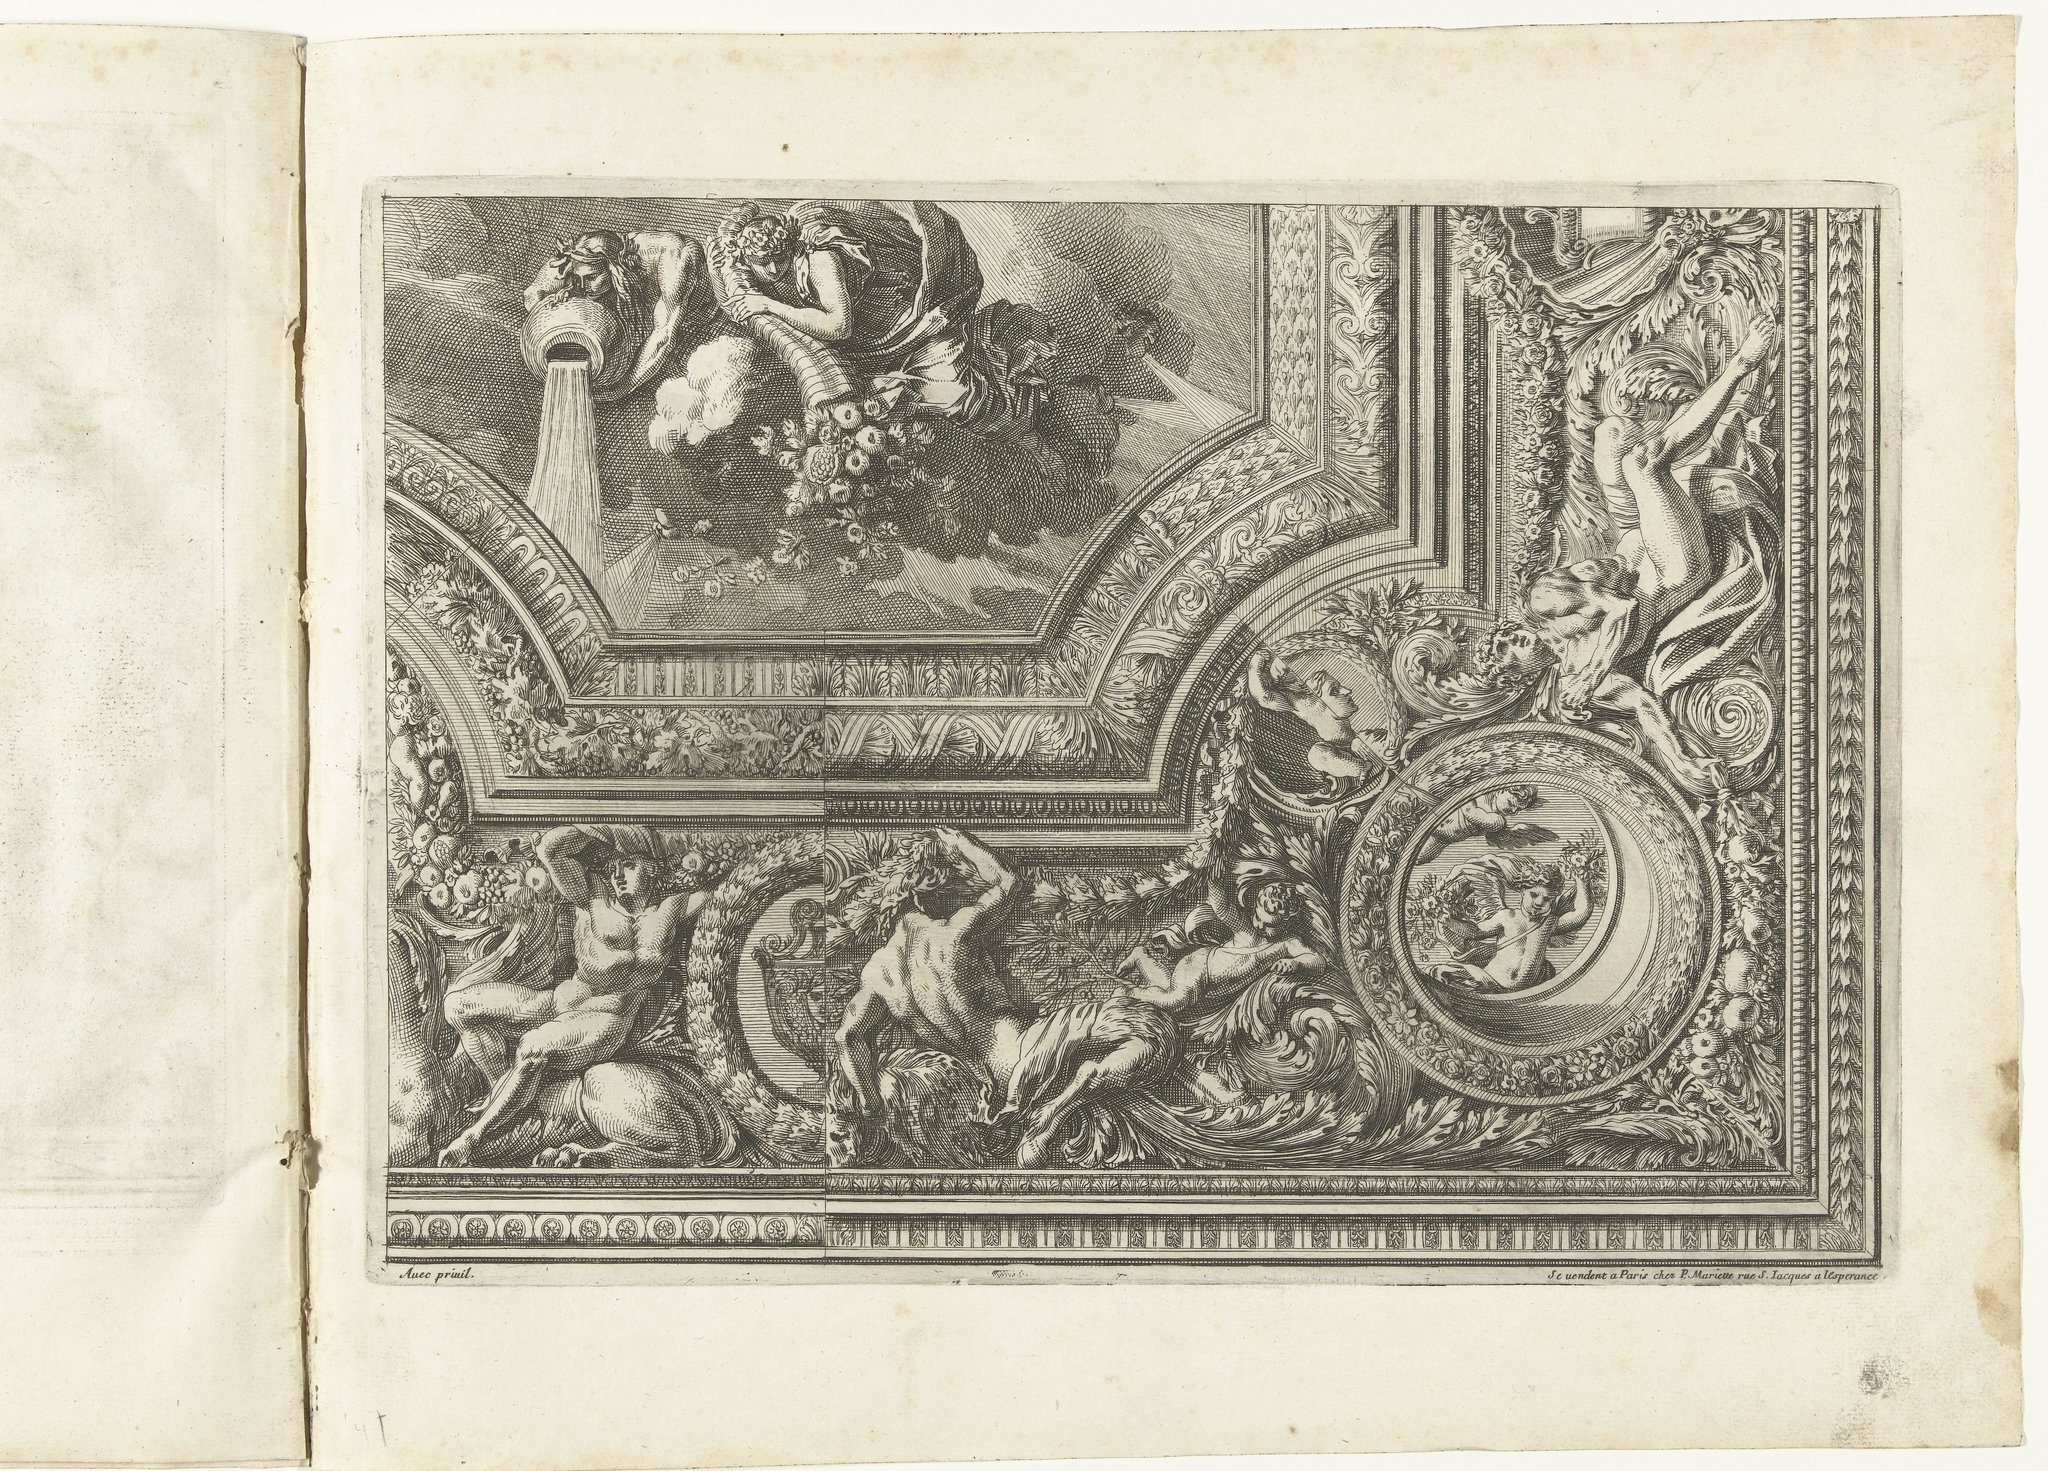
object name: ornament print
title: Plafond met Aurora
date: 1661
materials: paper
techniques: etching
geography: paris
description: Aurora strooit bloemen uit een hoorn des overvloeds. Met varianten voor drie maal een achtste gedeelte van de rand. Blad uit serie van 6 bladen met grote kwarten van plafonds in klassieke stijl, sommige met varianten voor de randen. Uit eerste editie.